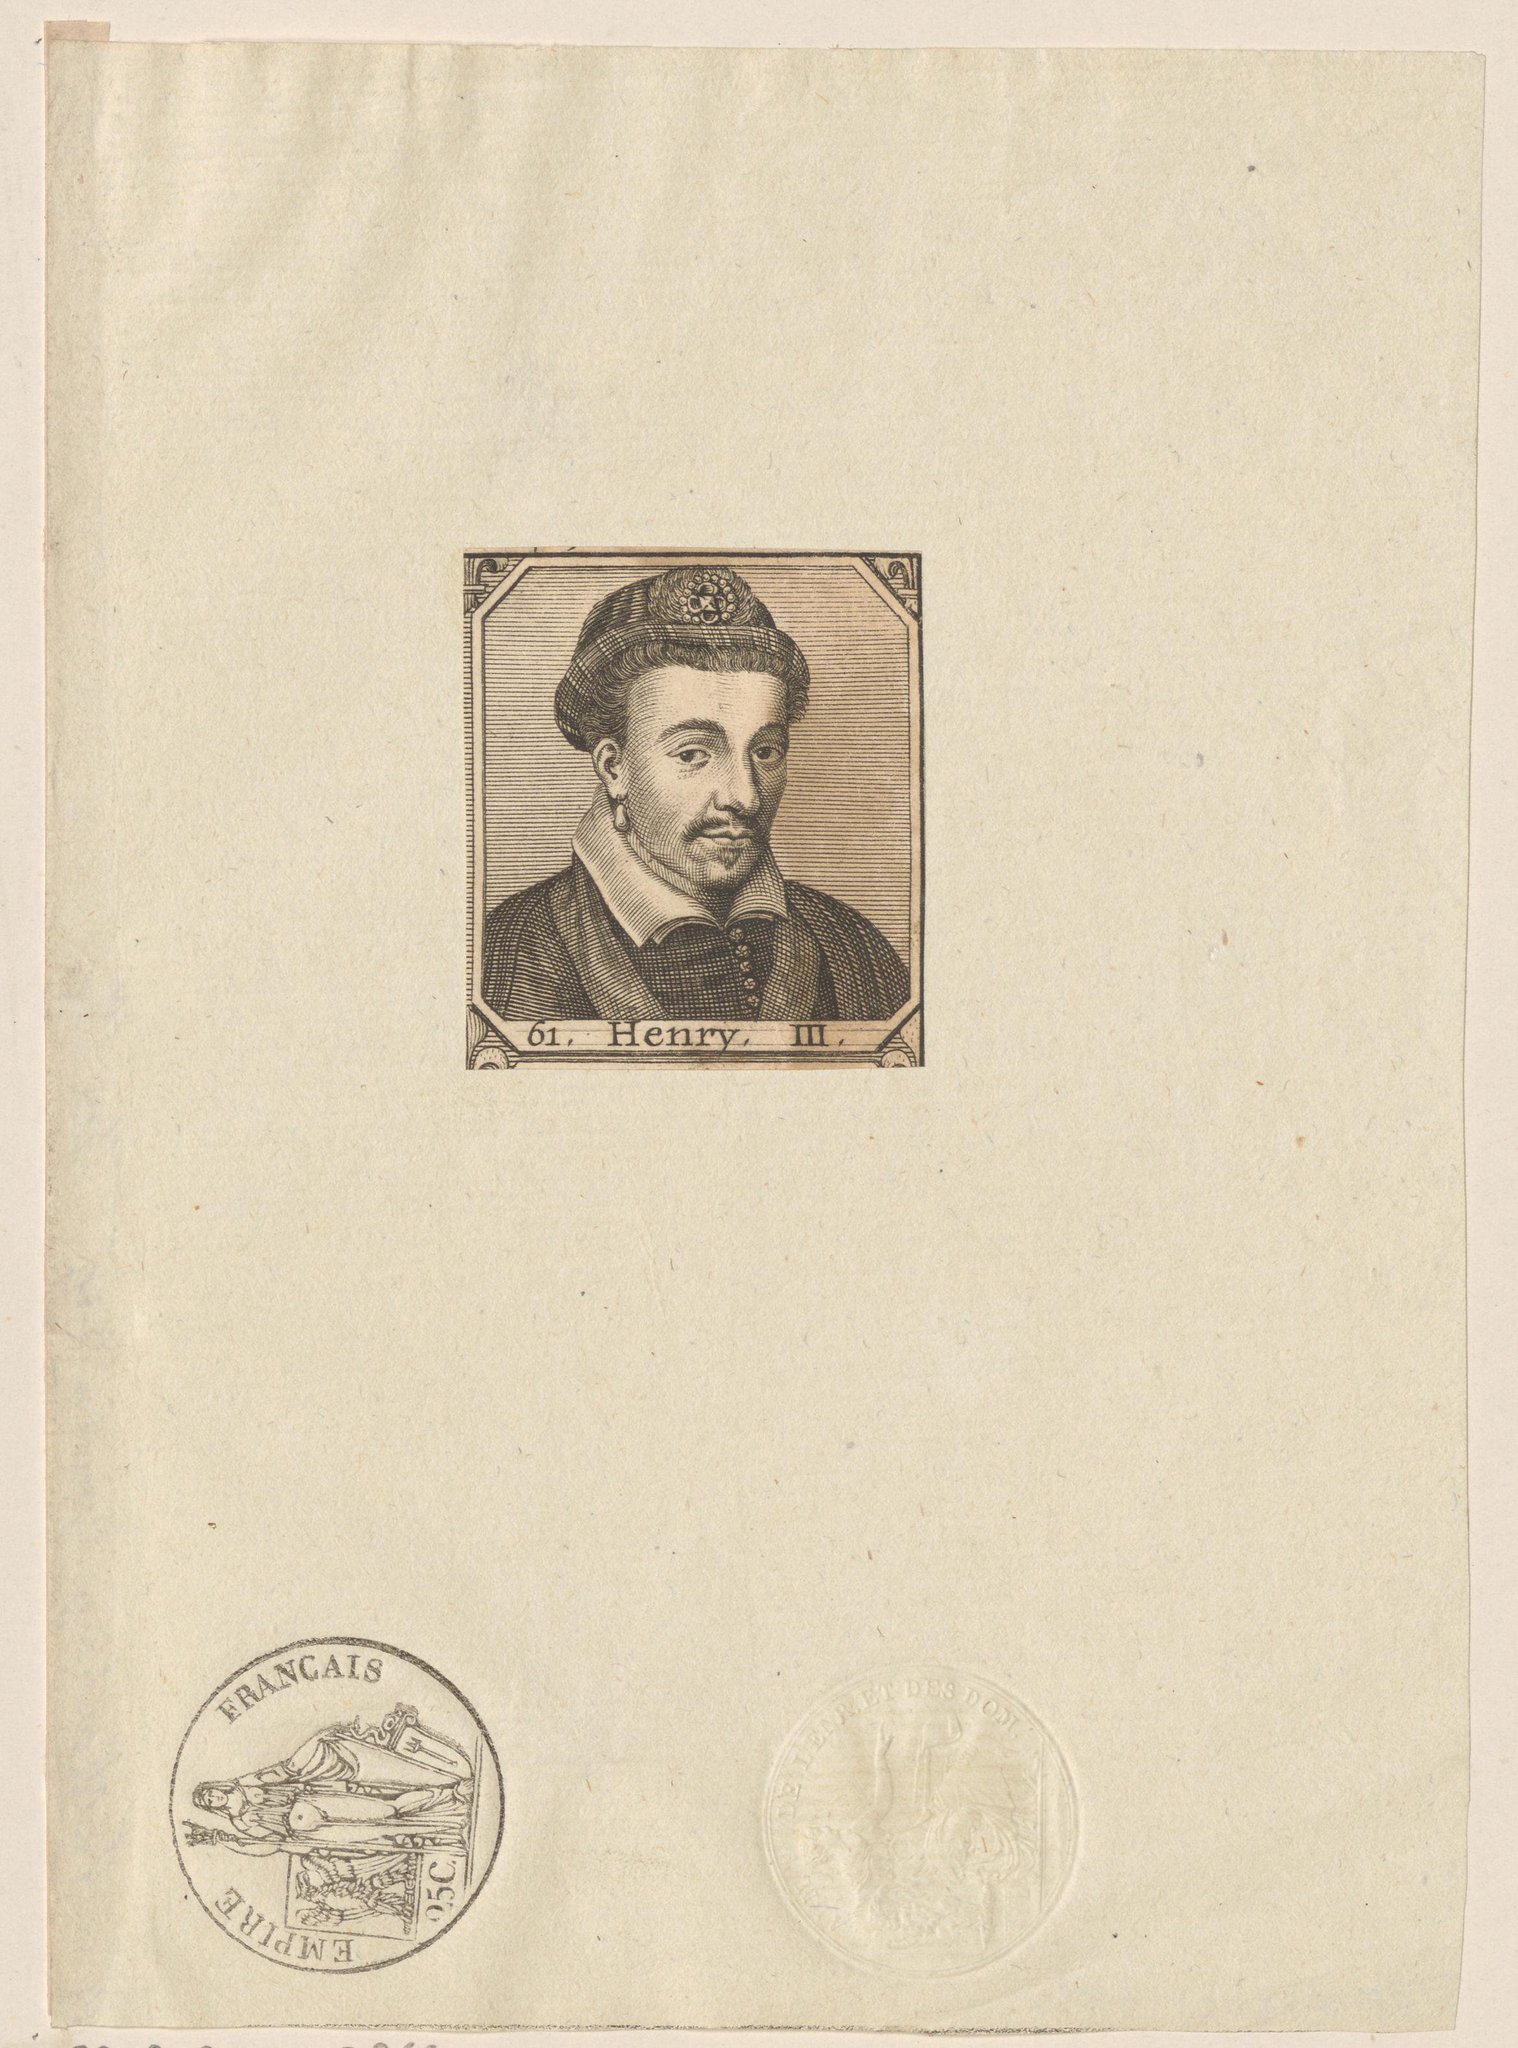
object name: print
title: Portret van Hendrik III, koning van Frankrijk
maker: Anonymous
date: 1700-1799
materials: paper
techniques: engraving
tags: hendrik iii (koning van frankrijk), historical persons, king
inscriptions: collector's mark: ‘Empire Francais’, collector's mark: ‘De l'enr. et des dom.’